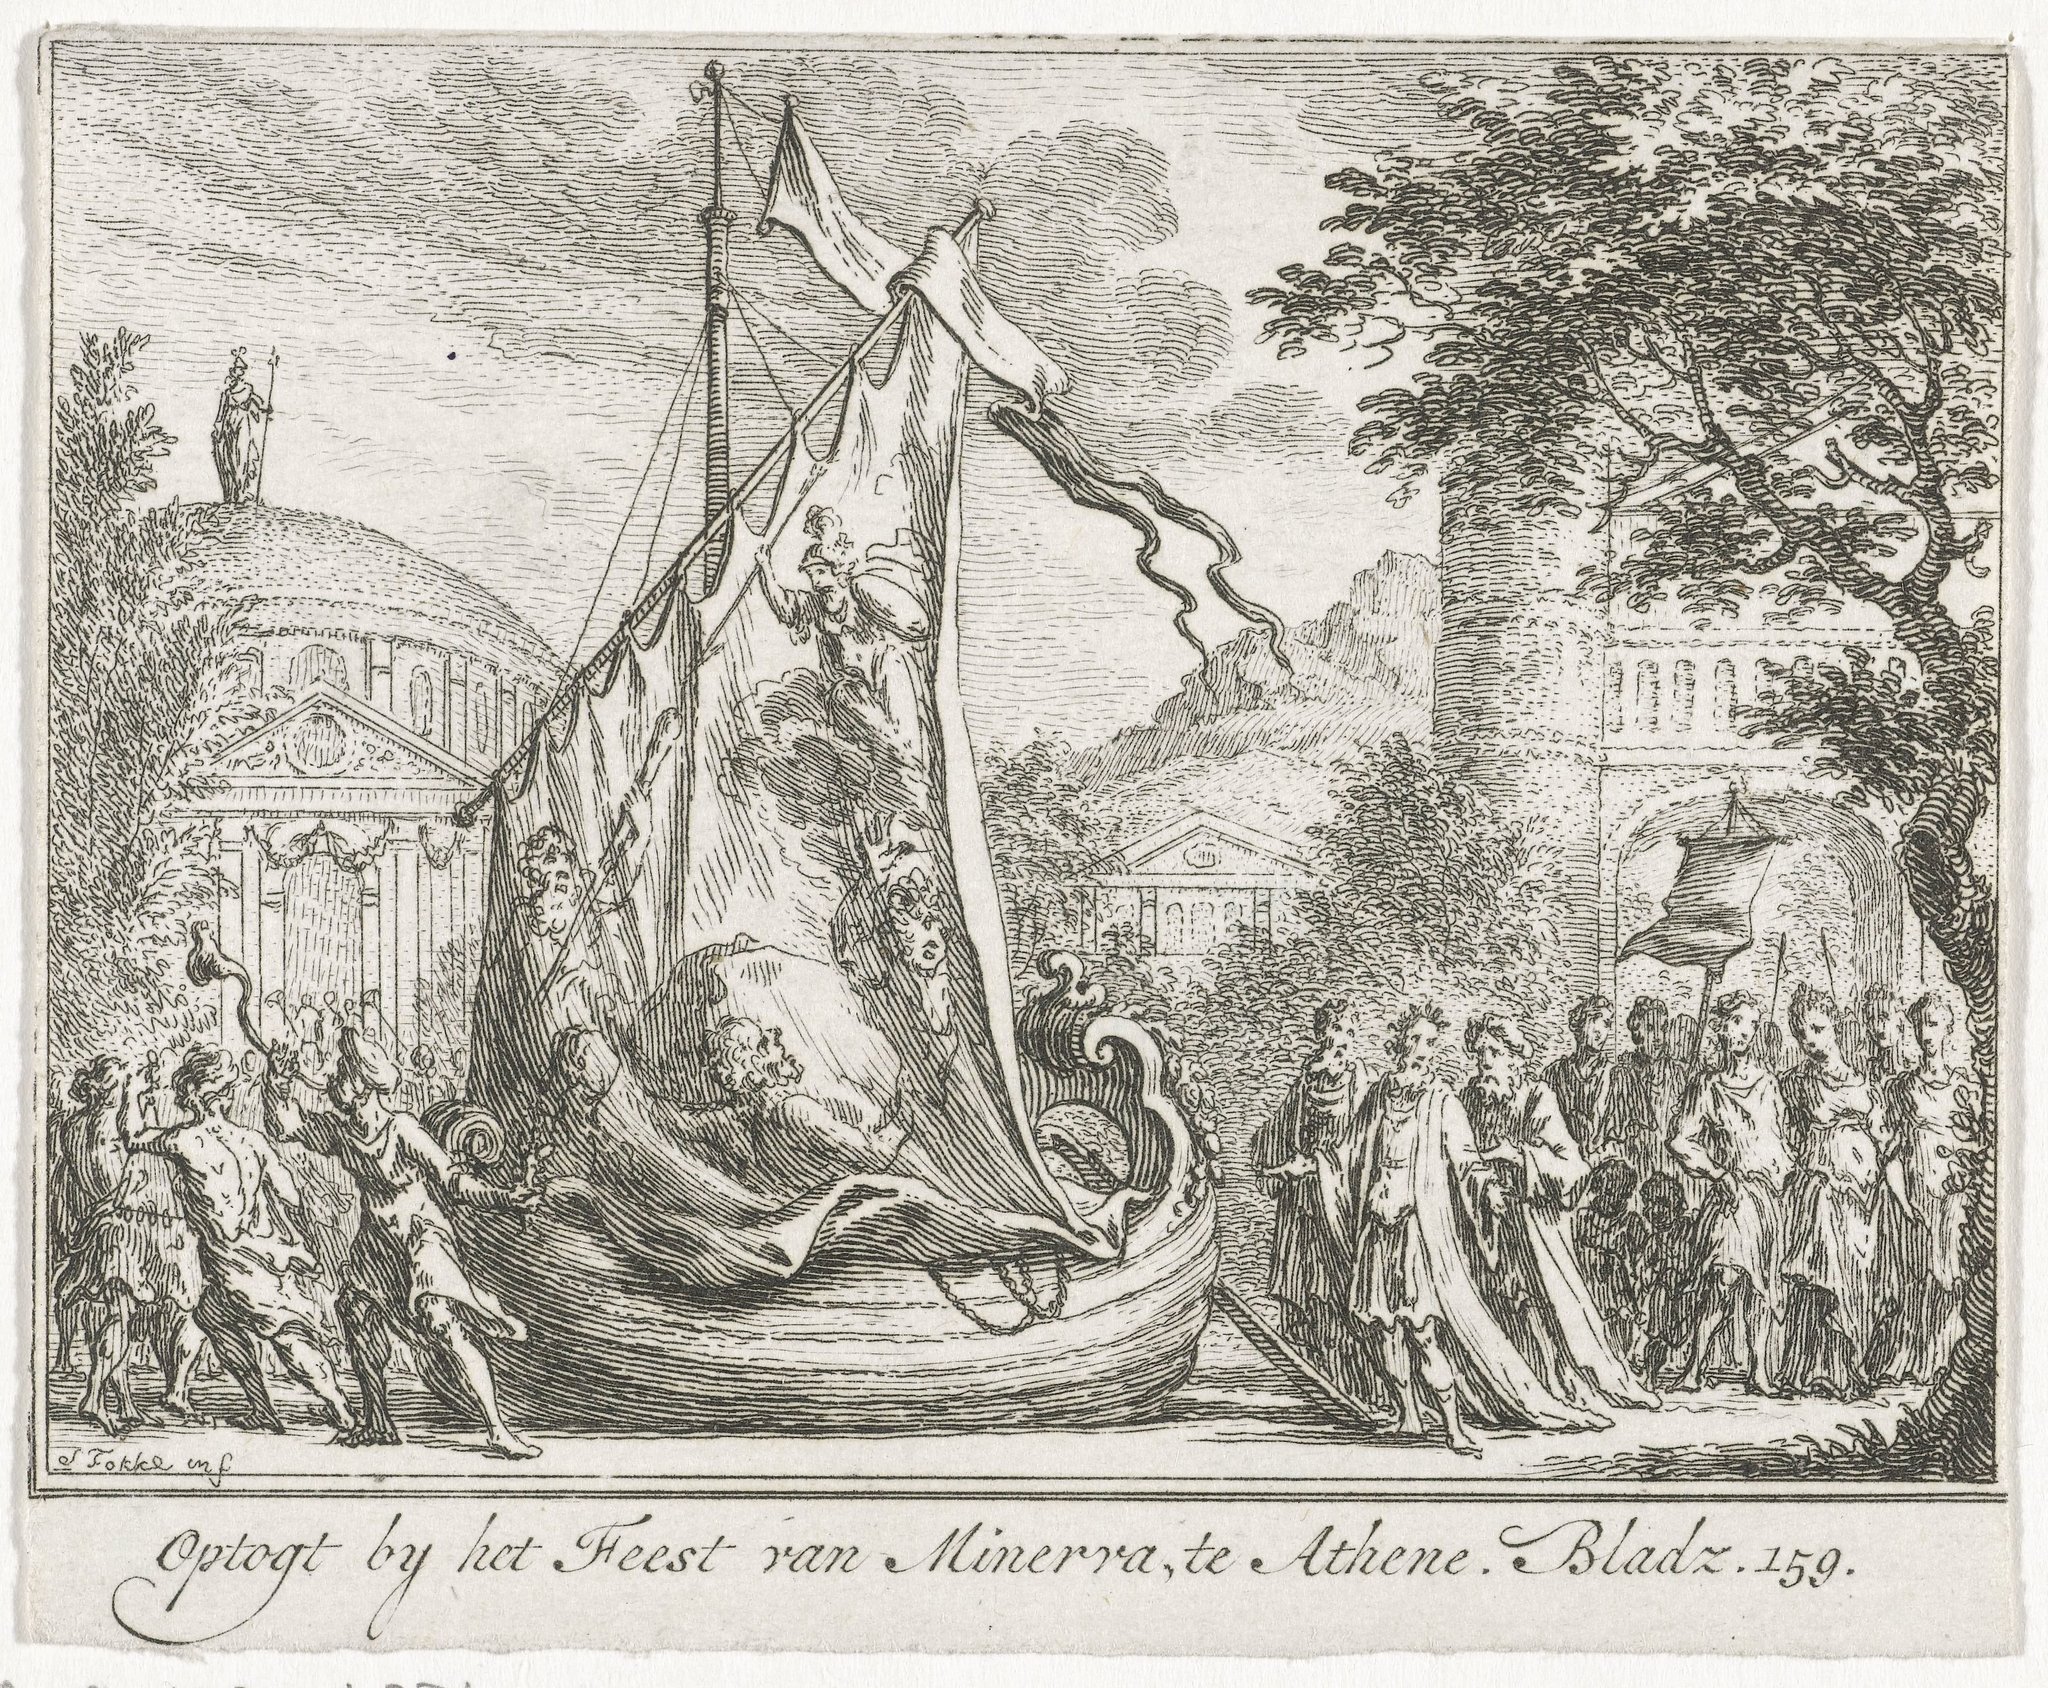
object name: print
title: Optogt by het Feest van Minerva te Athene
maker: simon fokke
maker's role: draughtsman, print maker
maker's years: 1712-1784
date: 1722-1784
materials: paper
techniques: etching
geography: amsterdam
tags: sailing-ship, sailing-boat, feasts and festivals in honour of the gods ~ non-christian religions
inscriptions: collector's mark: Lugt 2228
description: Optocht met figuren in antieke kledij waarbij enkele onder hen een zeilboot voorttrekken. Op de achtergrond gebouwen uit het oude Rome.